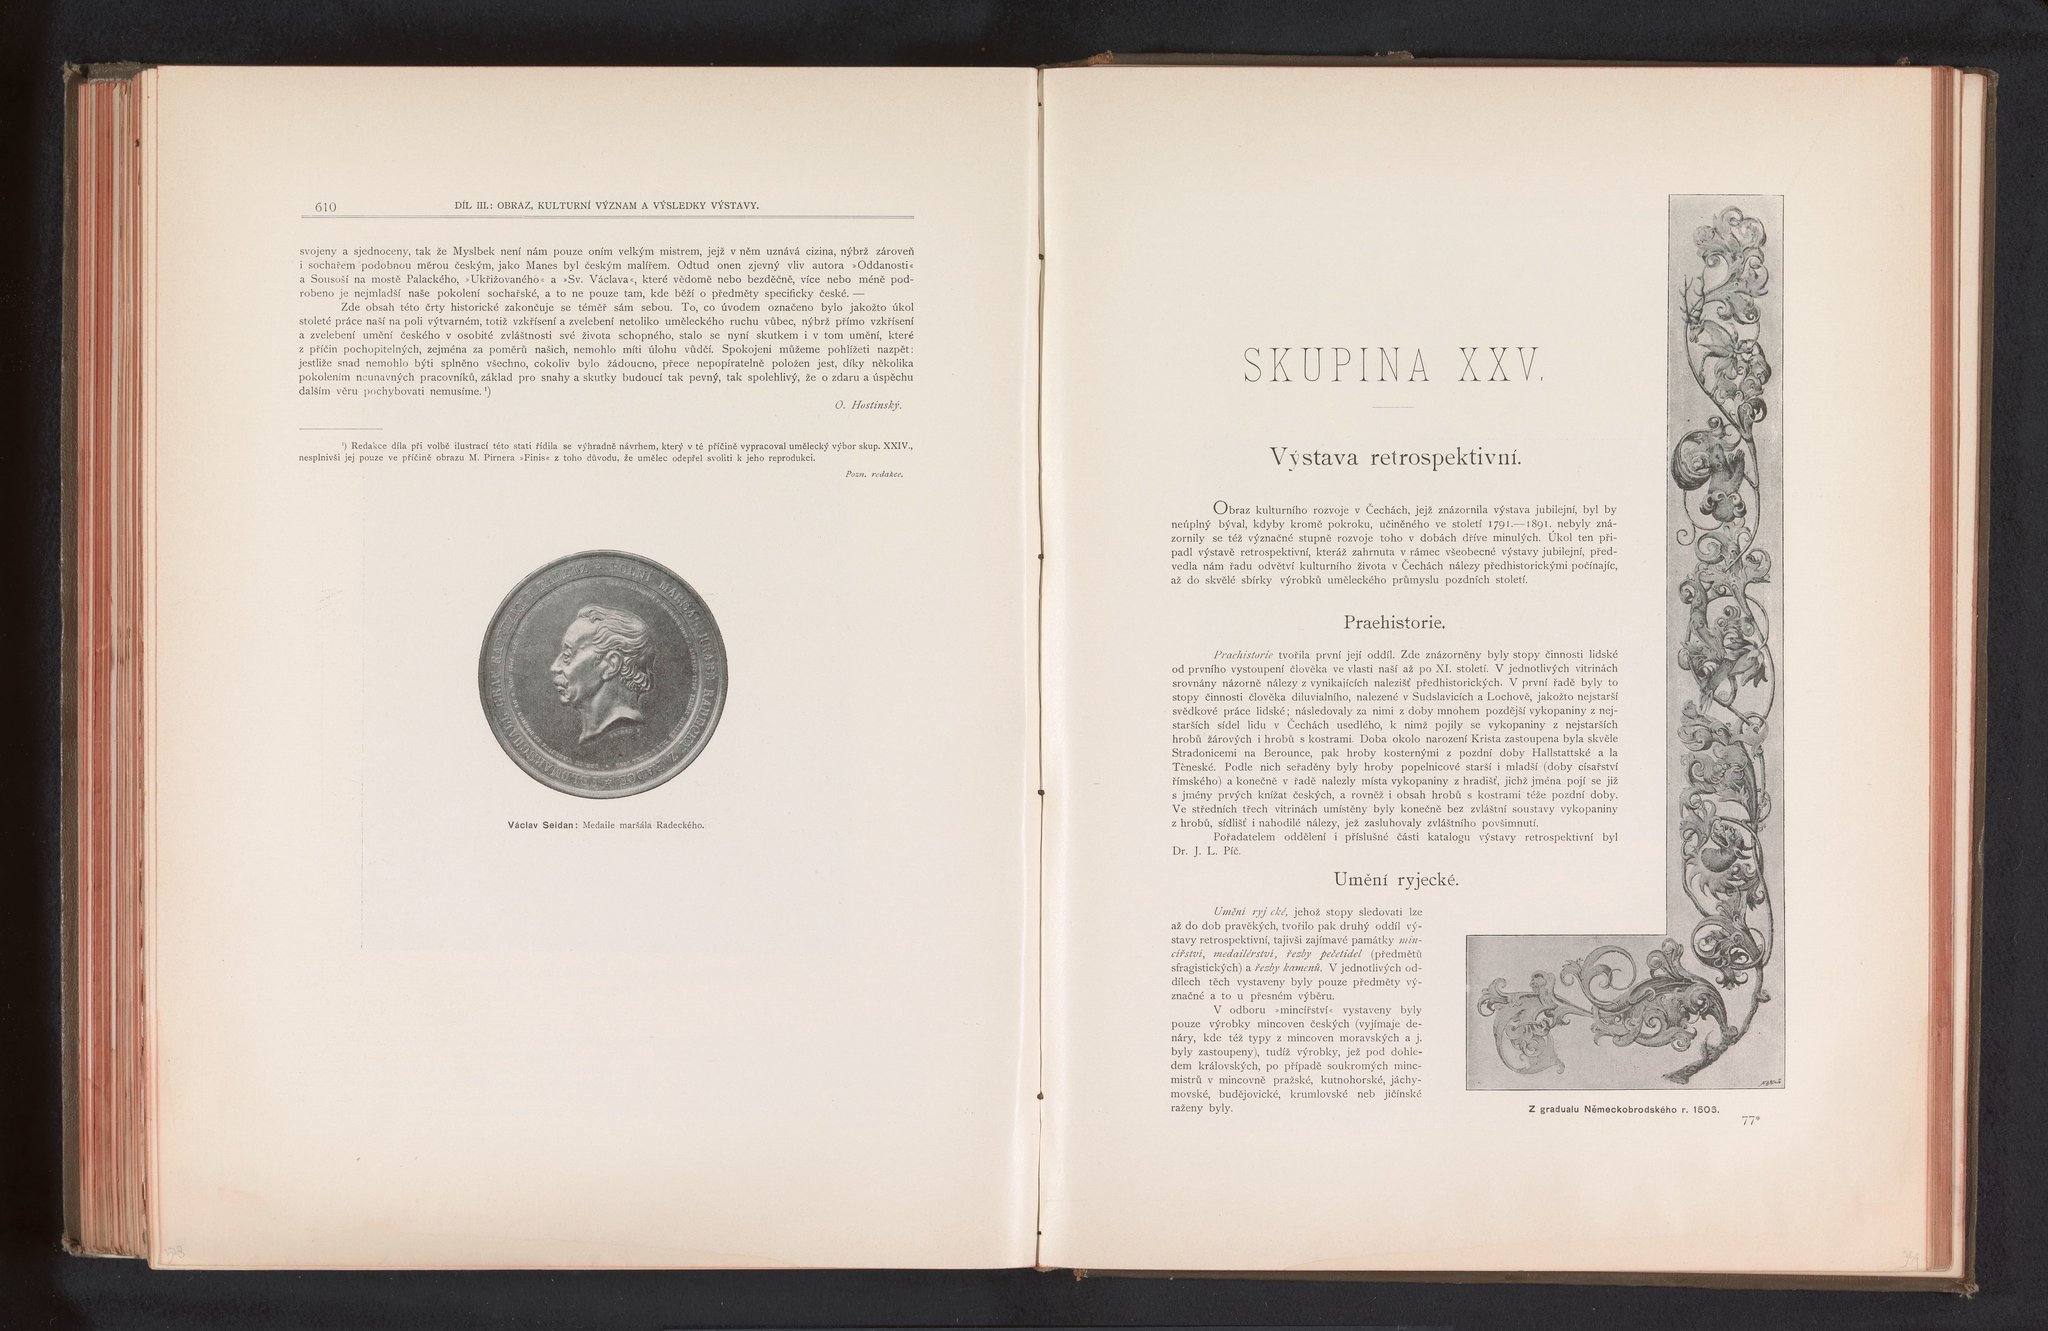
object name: photomechanical print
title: Fotoreproductie van een tekening, voorstellende bloemornament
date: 1891-1895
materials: paper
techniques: autotype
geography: prague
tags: bunch of flowers ~ ornament - aa - stylized